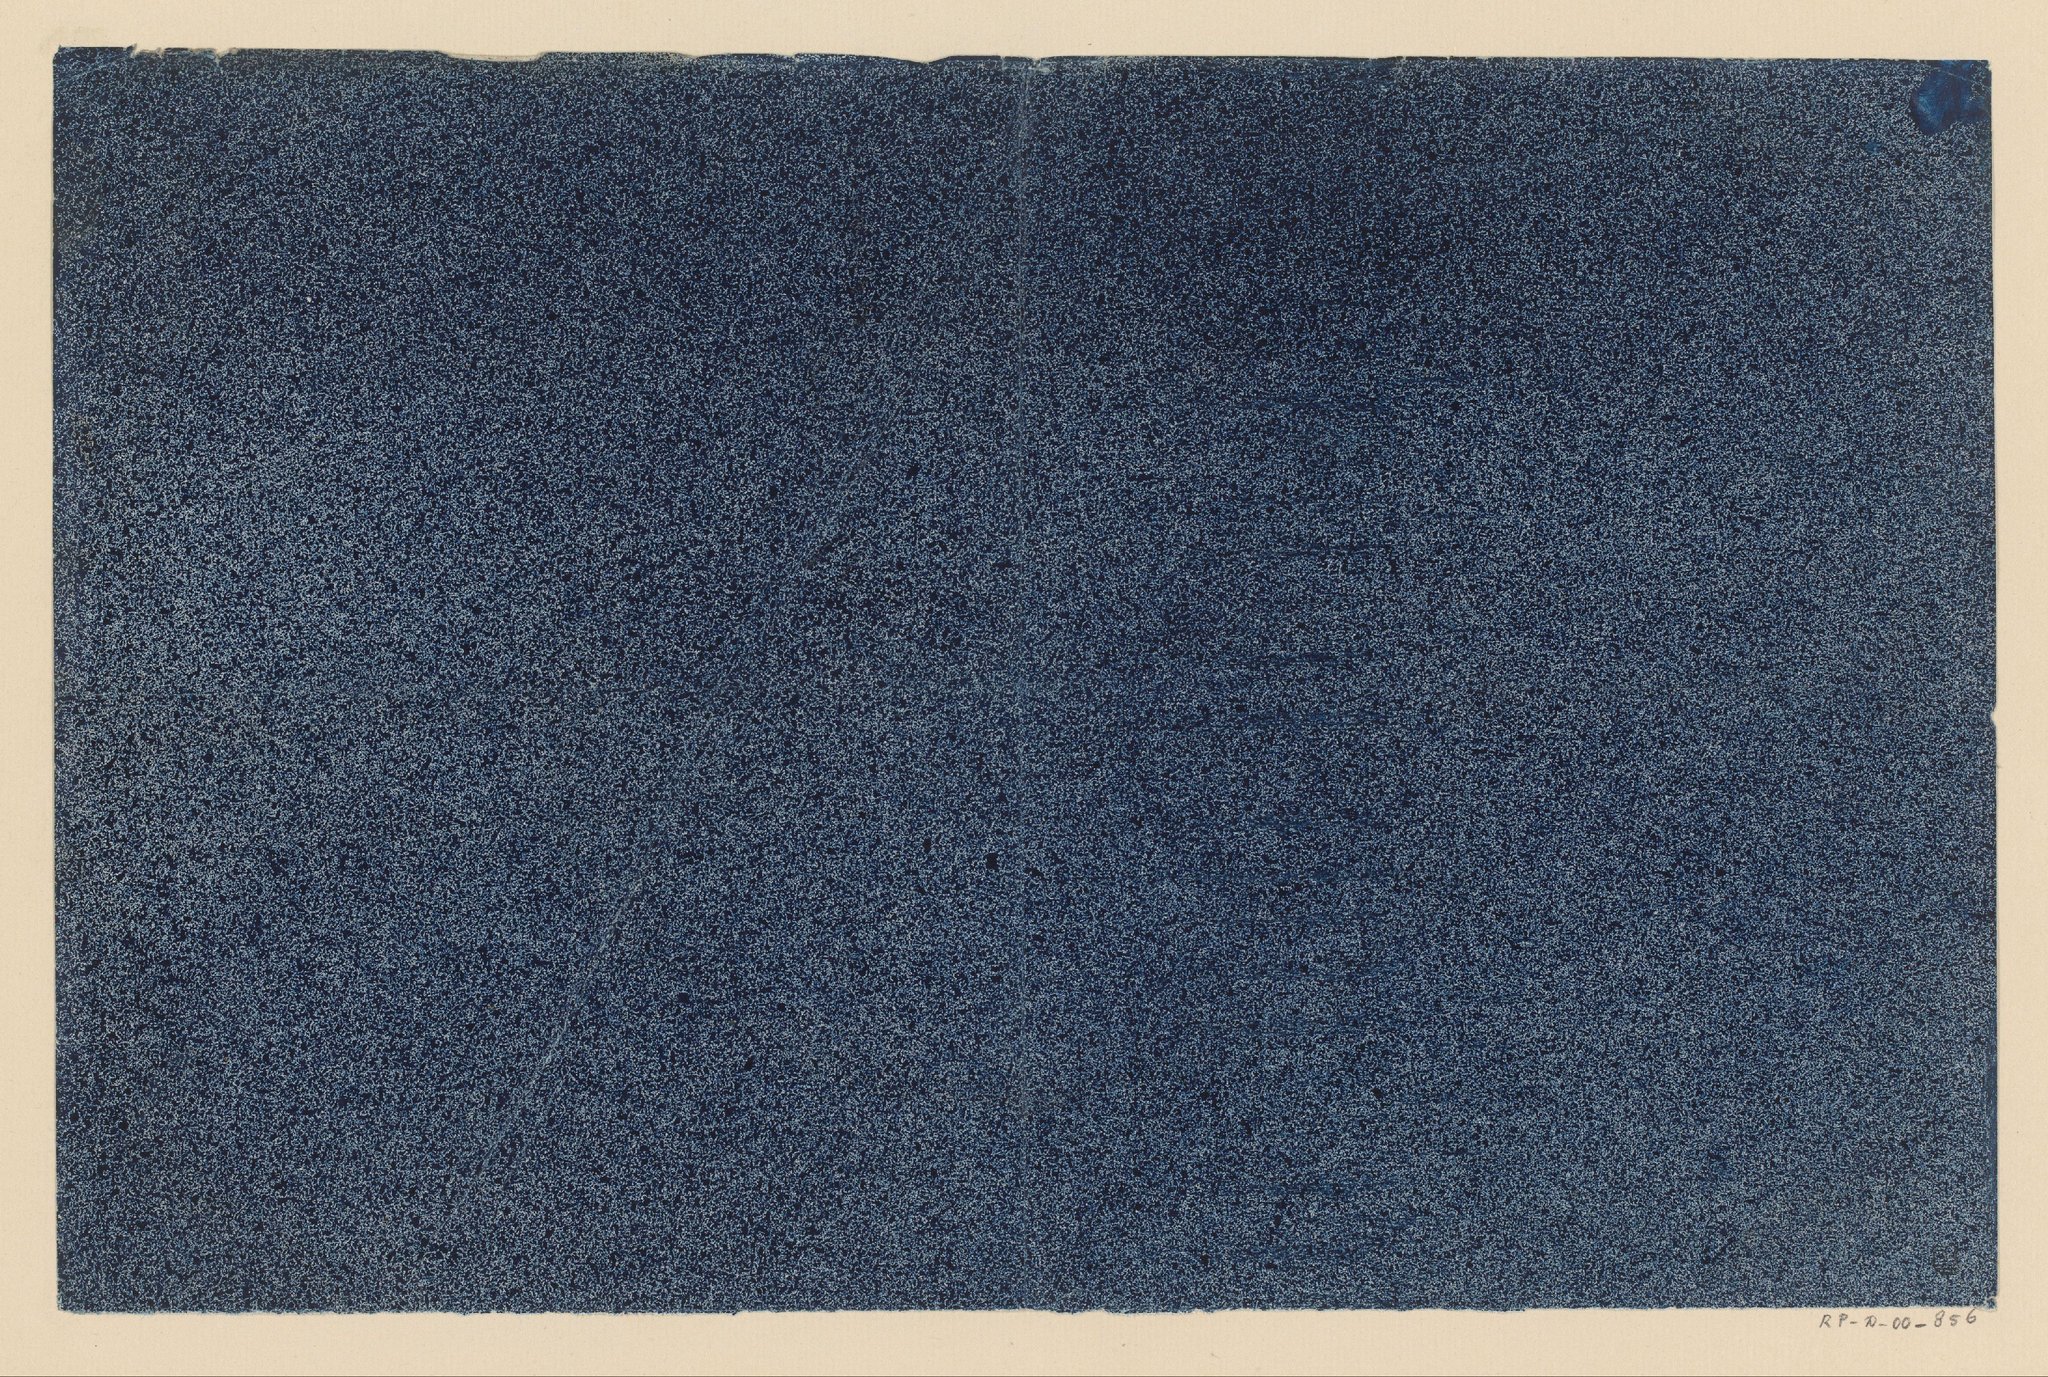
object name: sprinkled paper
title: Blauw gespikkeld papier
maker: Anonymous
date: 1750-1900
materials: paint, paper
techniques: splatter marble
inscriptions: collector's mark: Lugt 2760